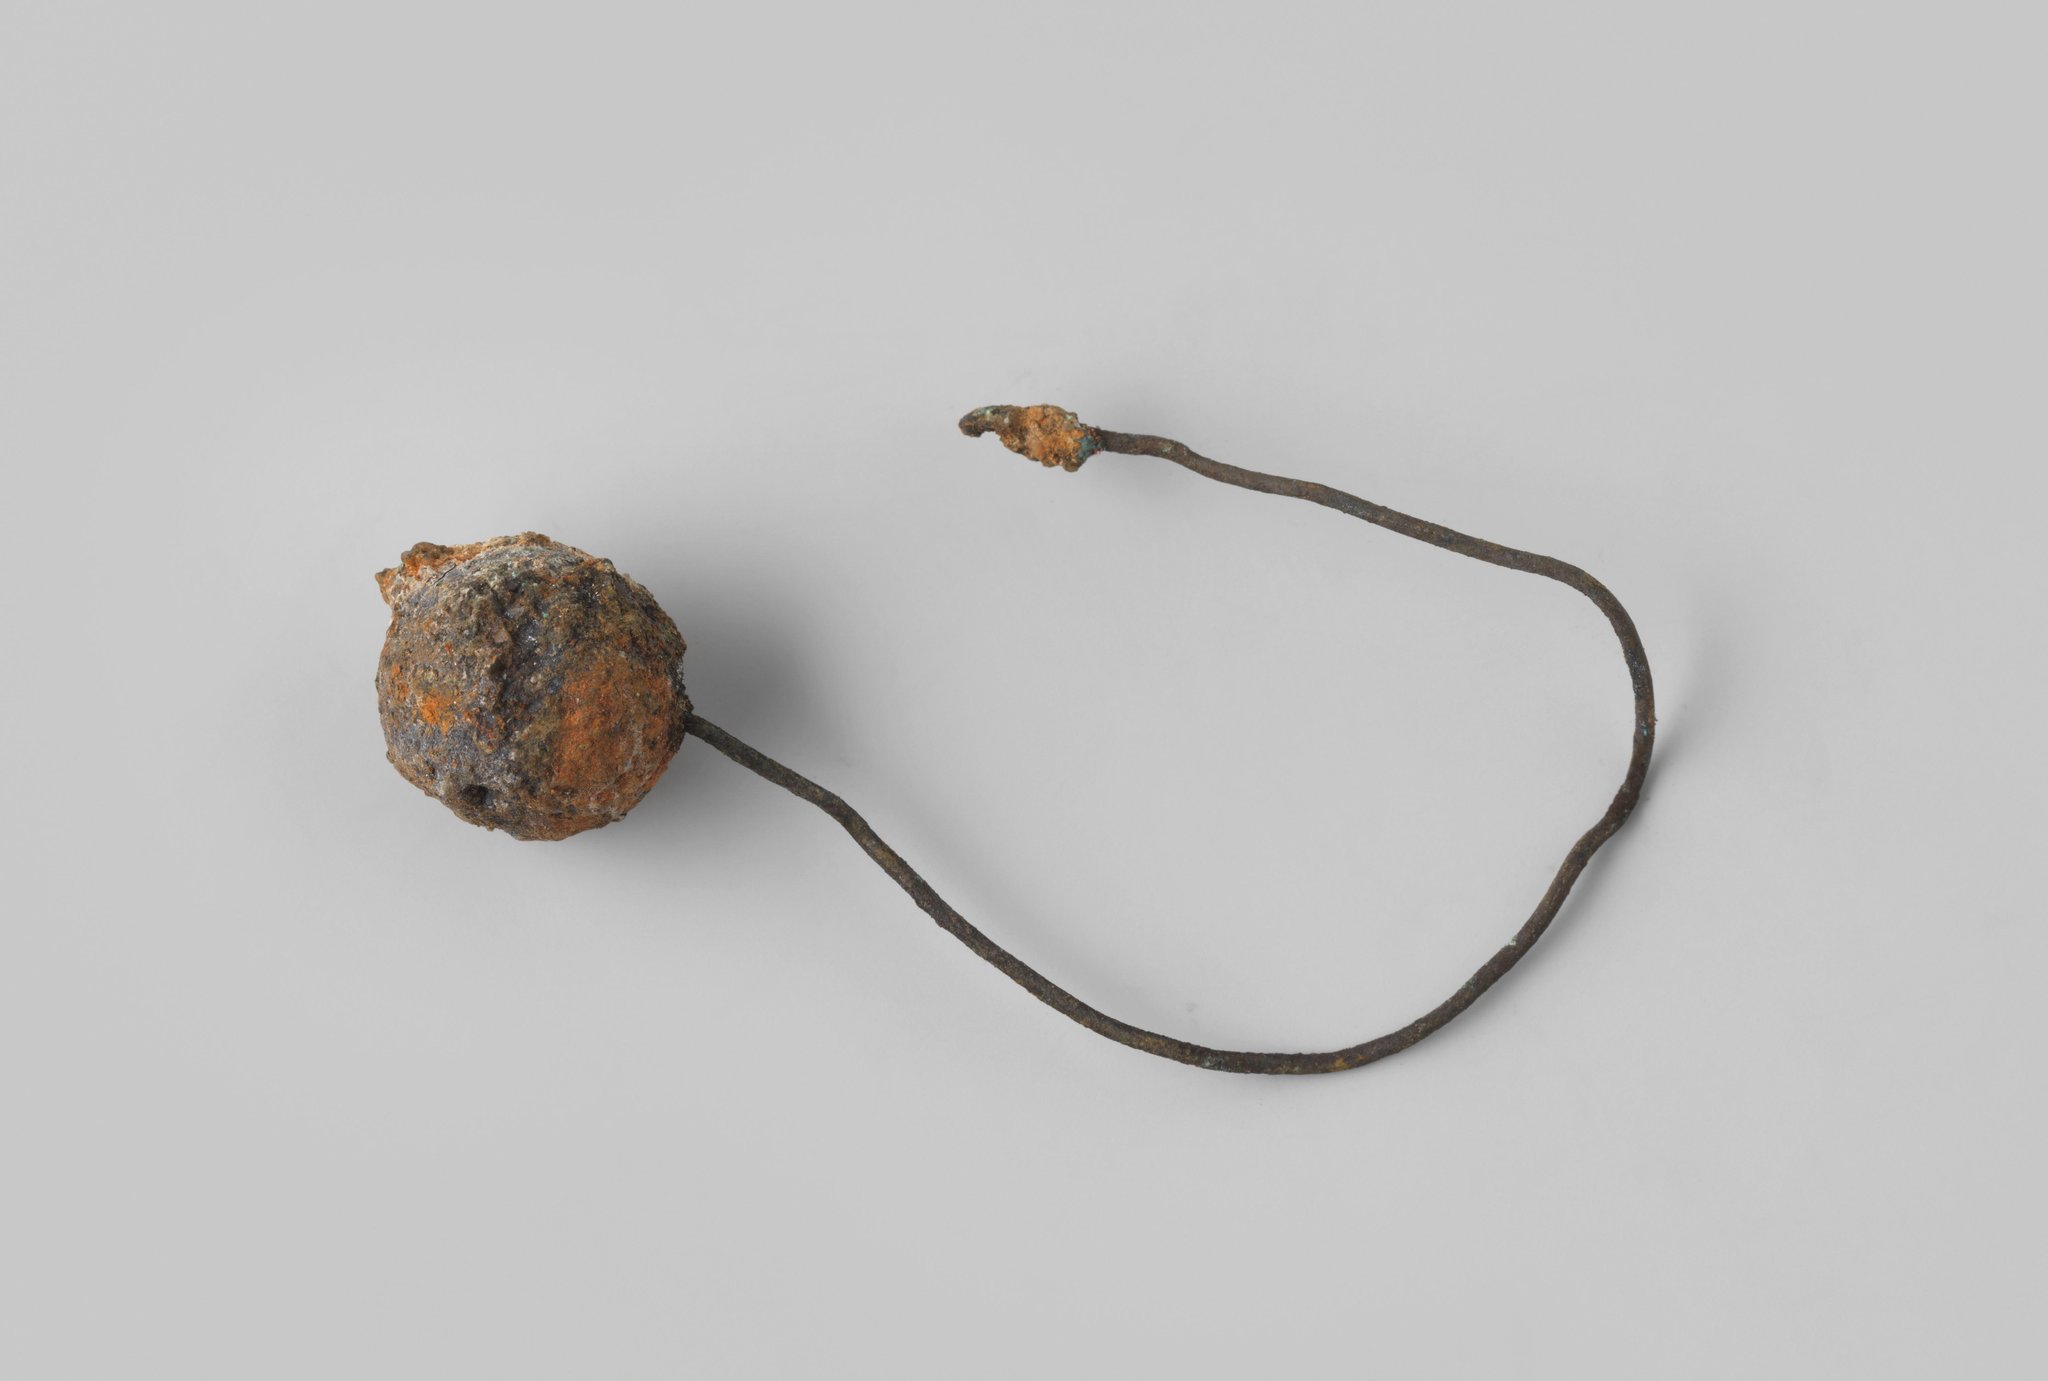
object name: chain shot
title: Kettingkogel uit het wrak van de Oost-Indiëvaarder Hollandia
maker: Anonymous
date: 1700-1743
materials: lead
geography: netherlands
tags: verenigde oostindische compagnie, hollandia (schip), annet